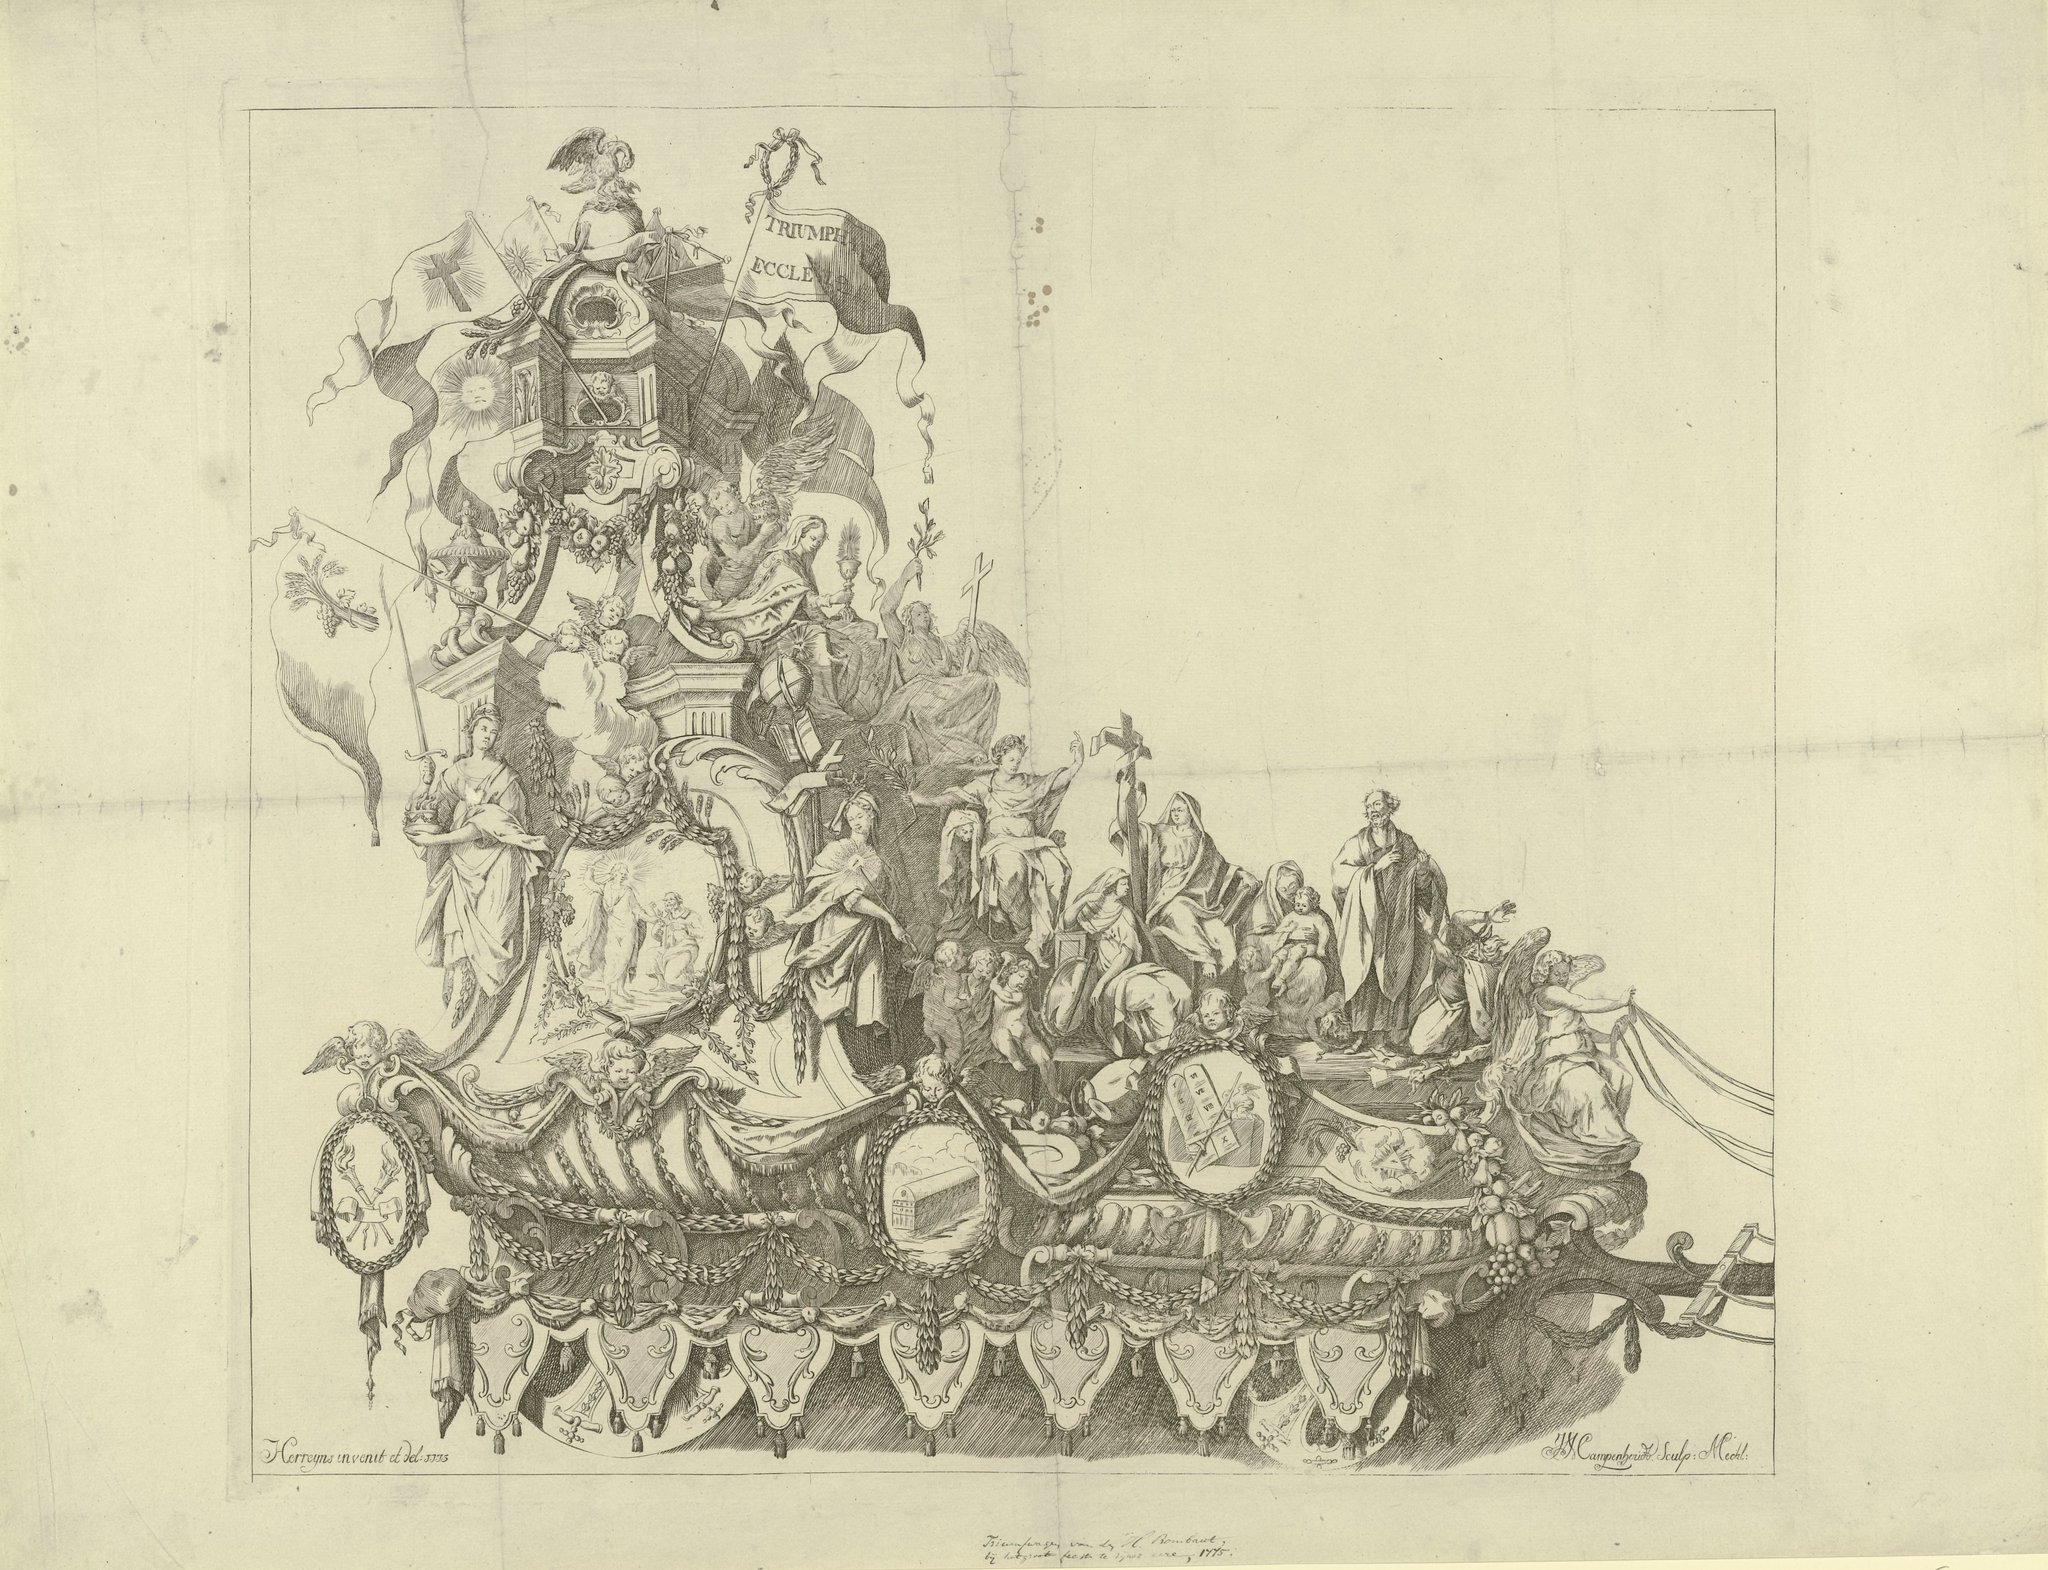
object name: print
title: Triomfwagen bij het 1000-jarig feest van de H. Rombout, 1775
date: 1775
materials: paper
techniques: engraving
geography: southern netherlands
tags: float ~ triumph, the hermit, martyr, and possibly former bishop of dublin, rum(b)old (rombaut) of malines; possible attributes: axe, hoe - apotheosis, glory, triumph of male saint, mechelen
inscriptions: collector's mark: Lugt 2228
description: Gebruikt als illustratie in: Description de la cavalcade (...) qui, á l'occasion du jubilé millenaire de saint Rombaut (...) sera exécutée les 26. & 27. de juin, 3. & 10. de juillet 1775. Mechelen: Joannes Franciscus vander Elst, 1775. Frederik Muller beschrijft deze optocht in 1775 als de herdenking van de 400ste sterfdag van de H. Rombout. De heilige is echter gestorven in 775, dus betreft het de duizendste verjaardag van het overlijden van de heilige.